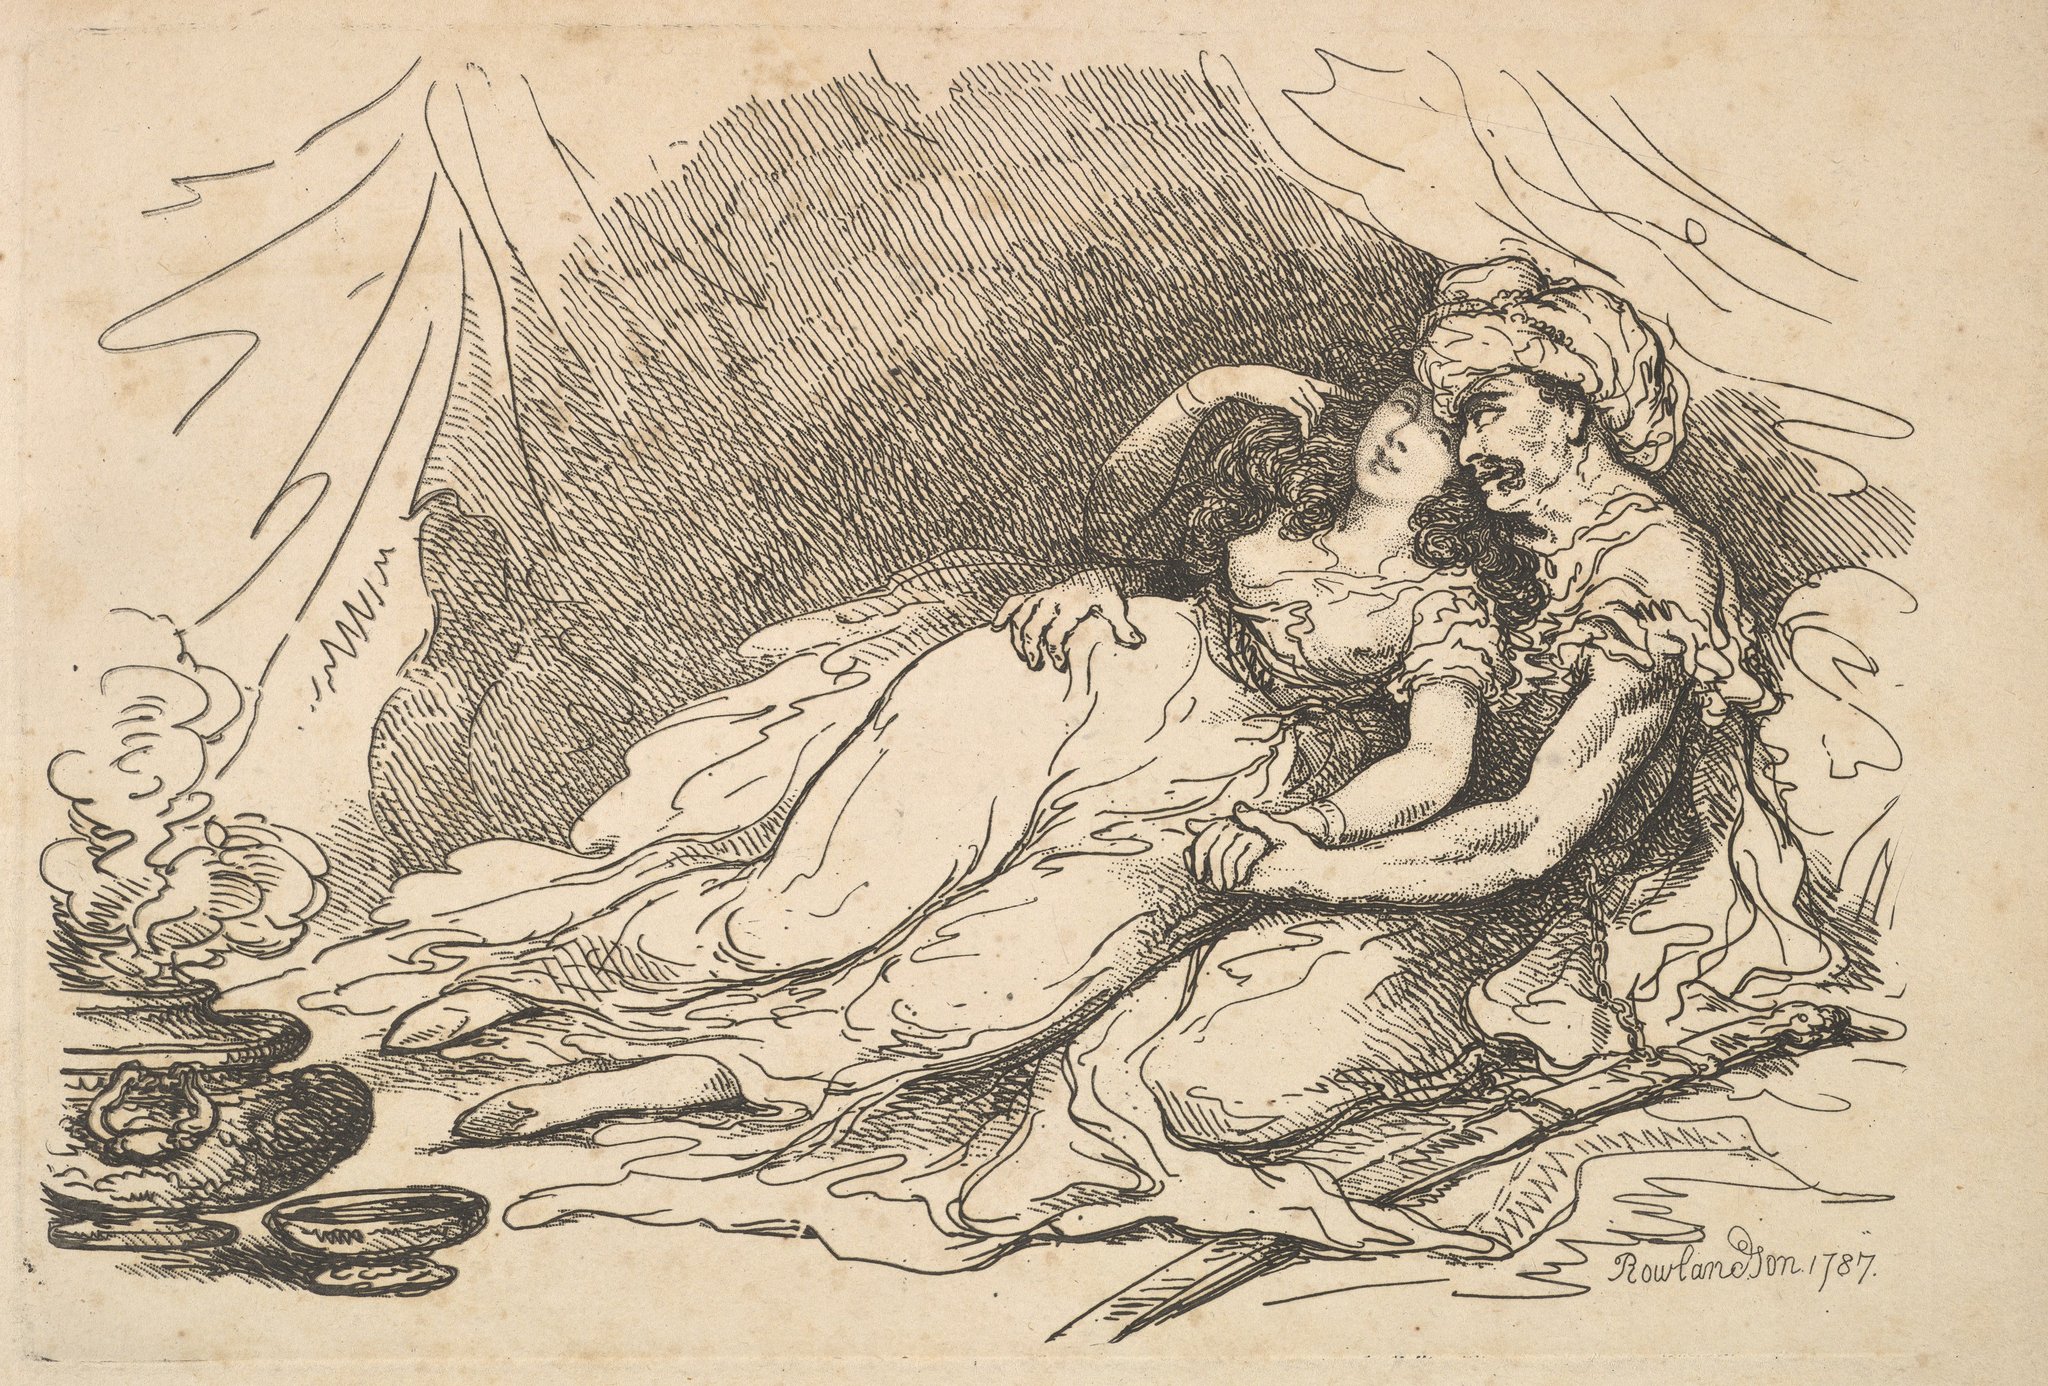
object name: print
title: Love in the East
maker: thomas rowlandson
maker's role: artist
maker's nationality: british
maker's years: 1757-1827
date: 1787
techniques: etching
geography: england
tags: couples,men,women